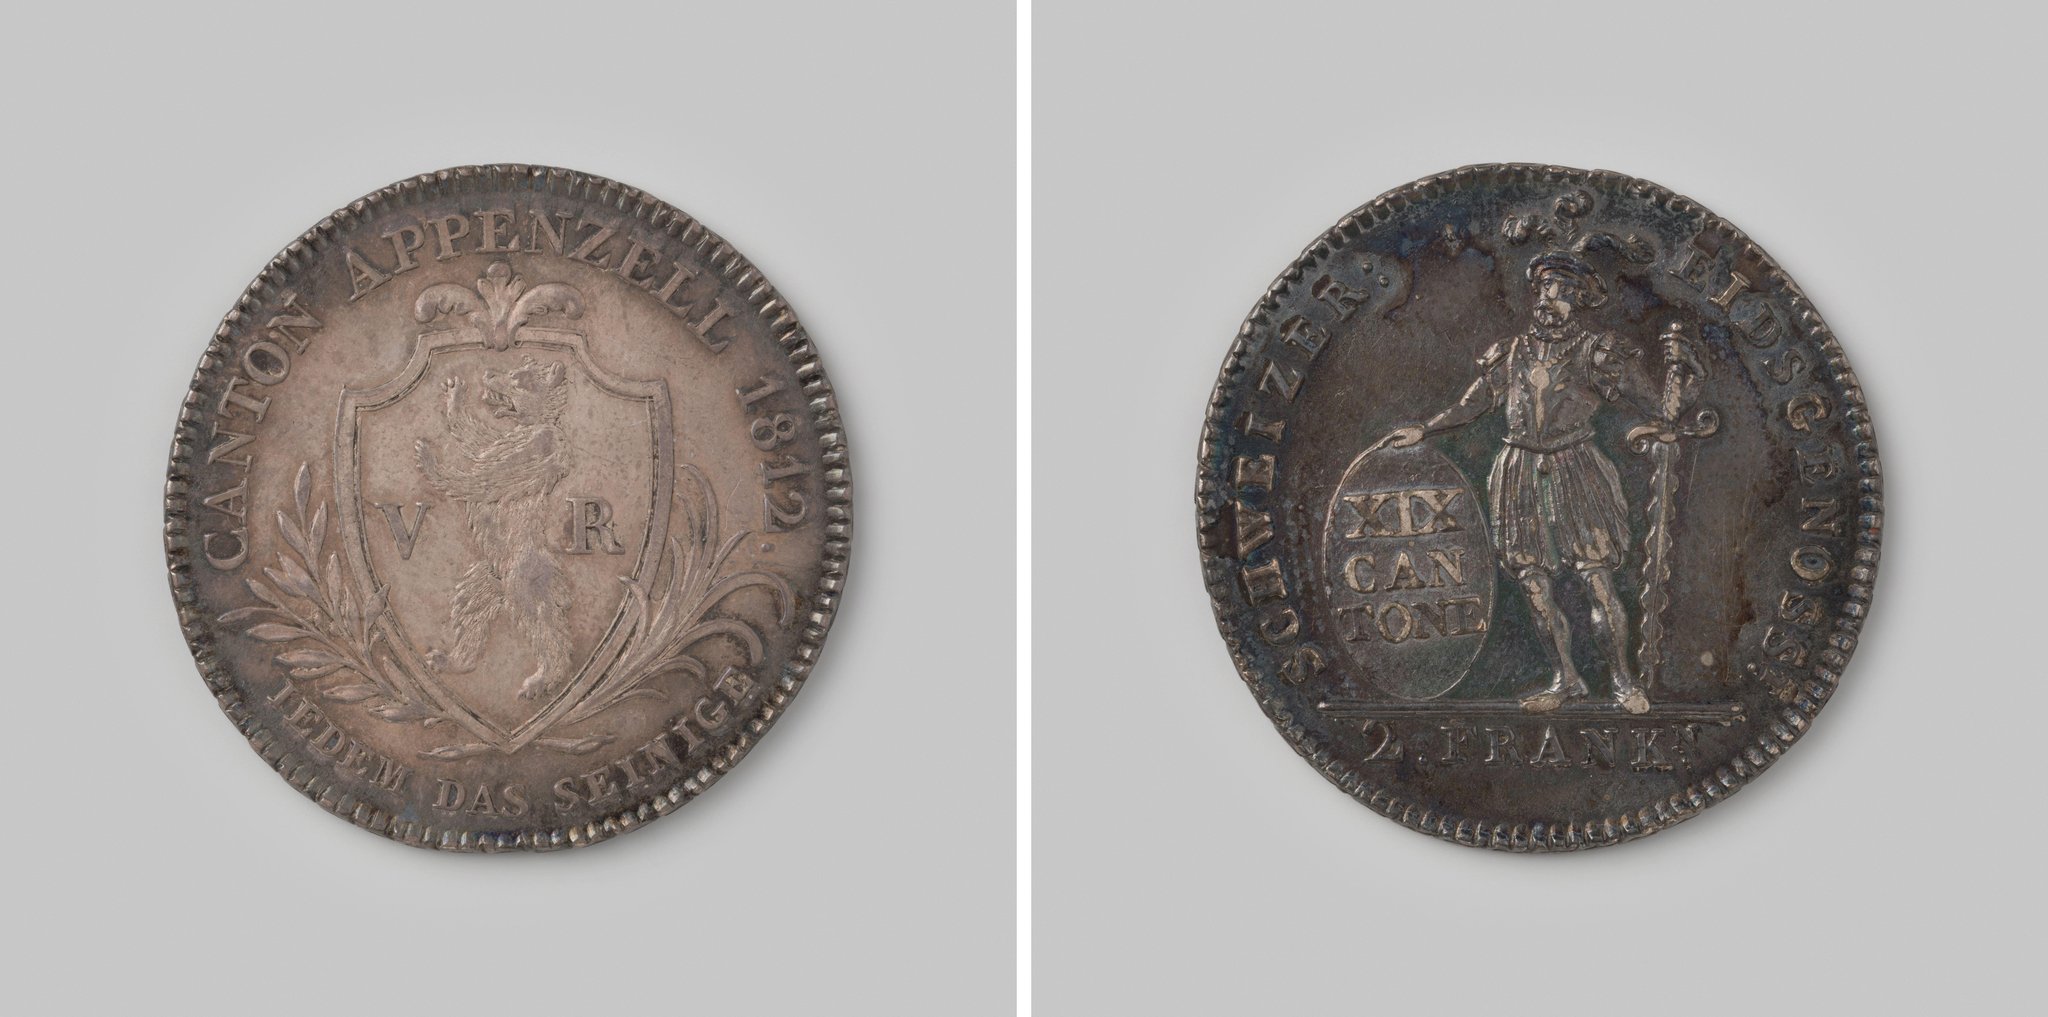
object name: coin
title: 2 Franken uit het kanton Appenzell, 1812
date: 1812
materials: silver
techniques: striking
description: Zilveren munt. Voorzijde: tussen twee takken wapenschild, waarboven pluim. Jaartal in omschrift. Keerzijde: staande man met hoed, waarop pluim. In zijn linkerhand een zwaard en met zijn rechterhand een schild vasthoudend. In afsnede waarde-aanduiding. Bloemrand.